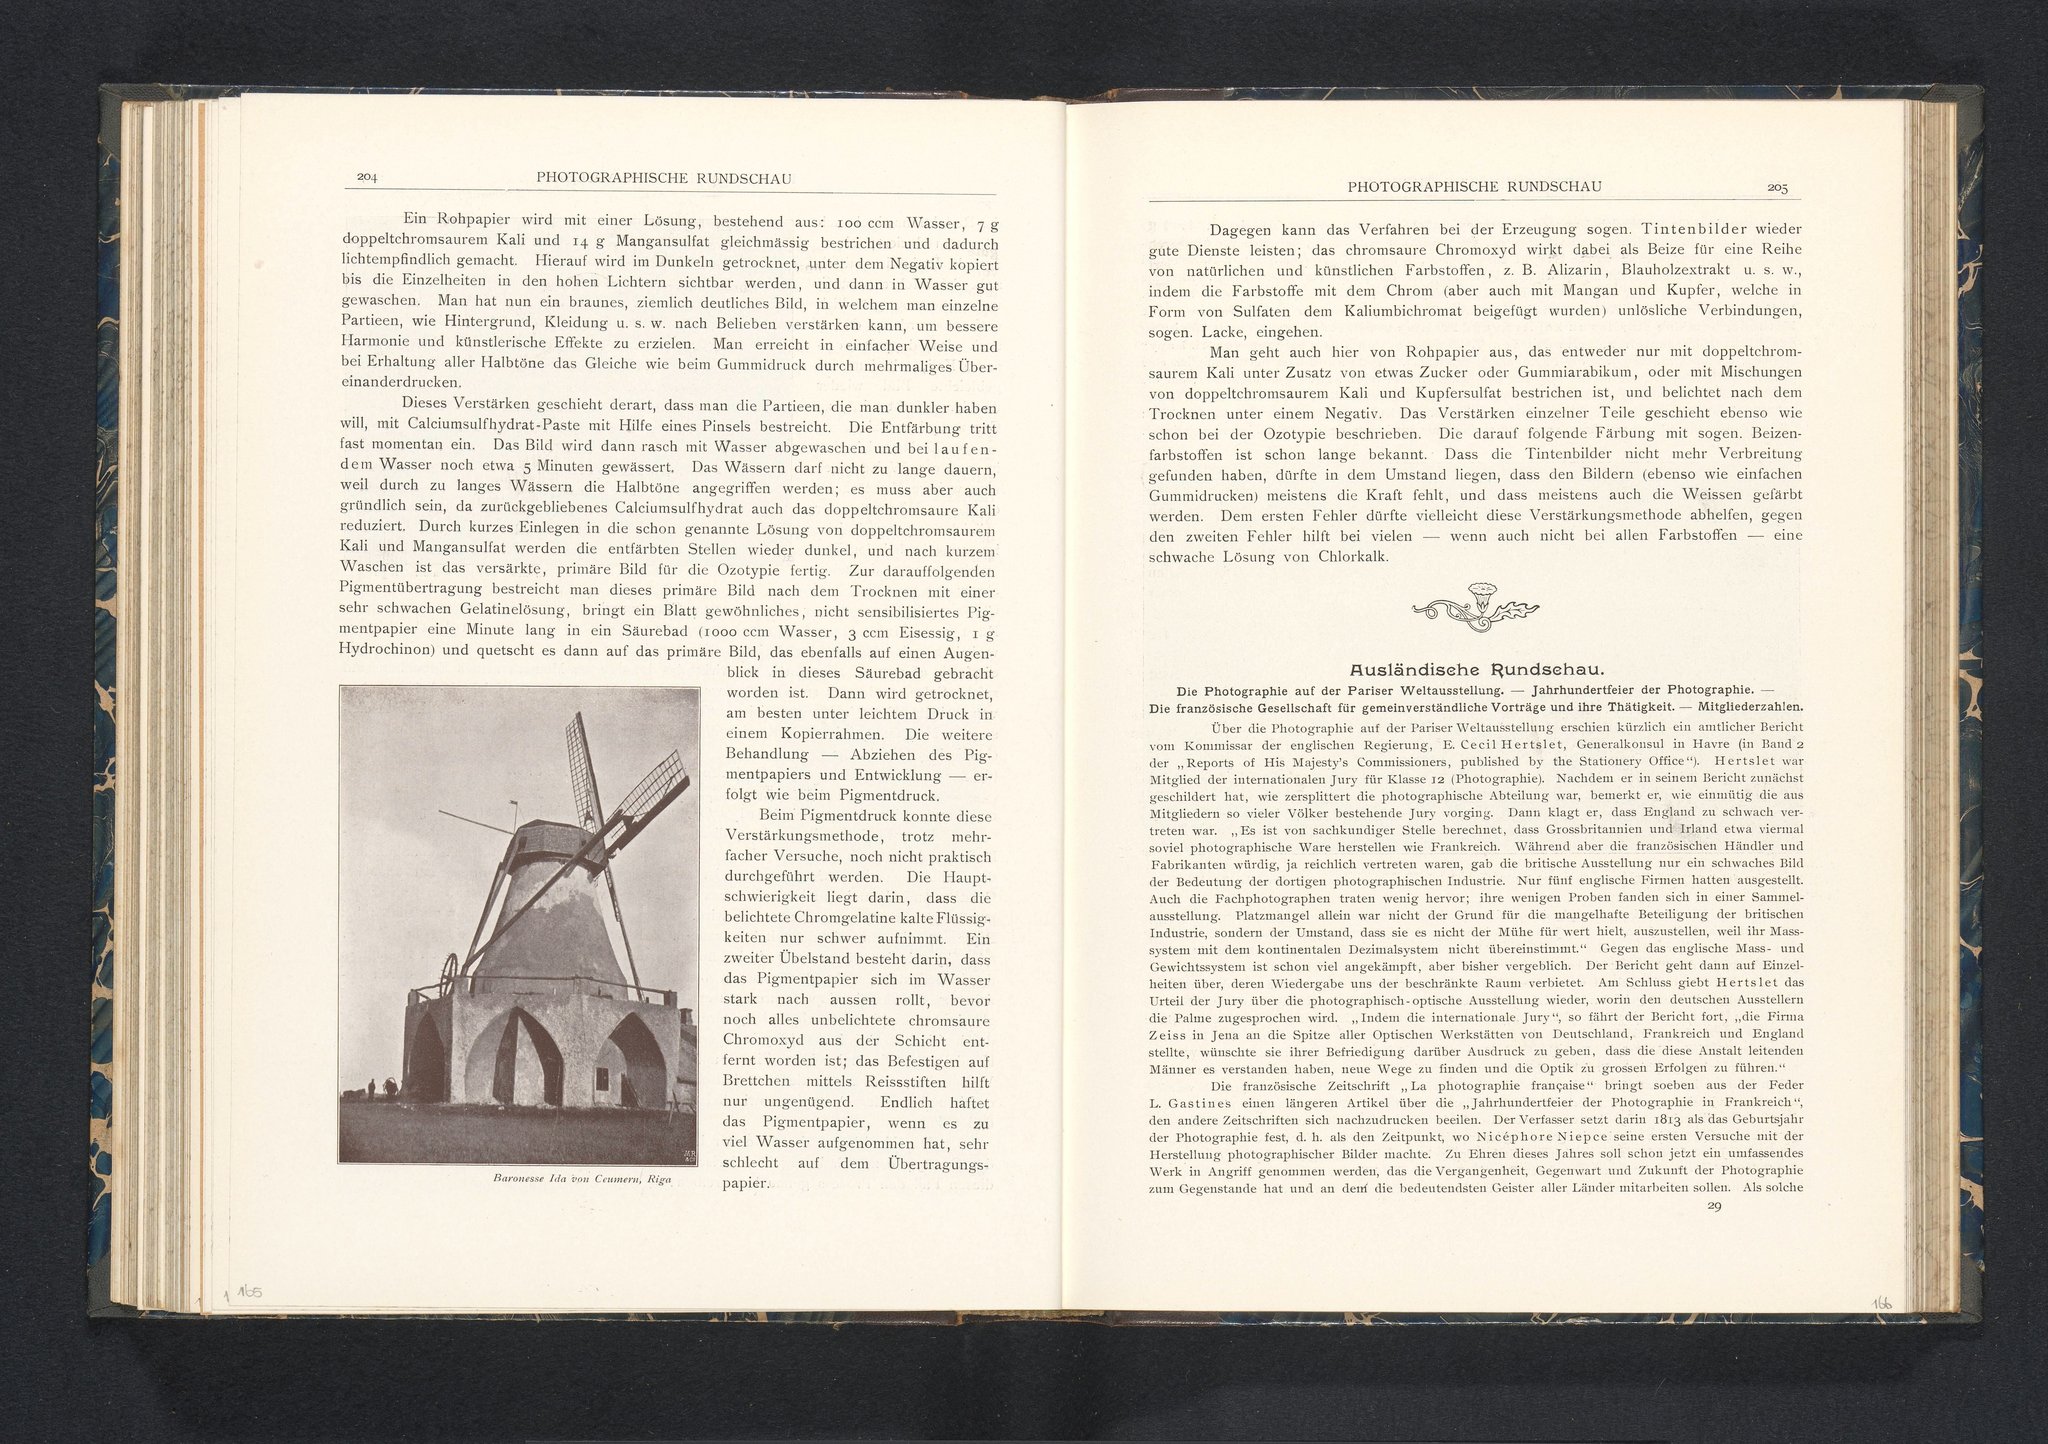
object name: photomechanical print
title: Gezicht op een molen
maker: ida von ceumern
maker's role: barones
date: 1896-1901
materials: paper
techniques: autotype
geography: berlin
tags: windmill